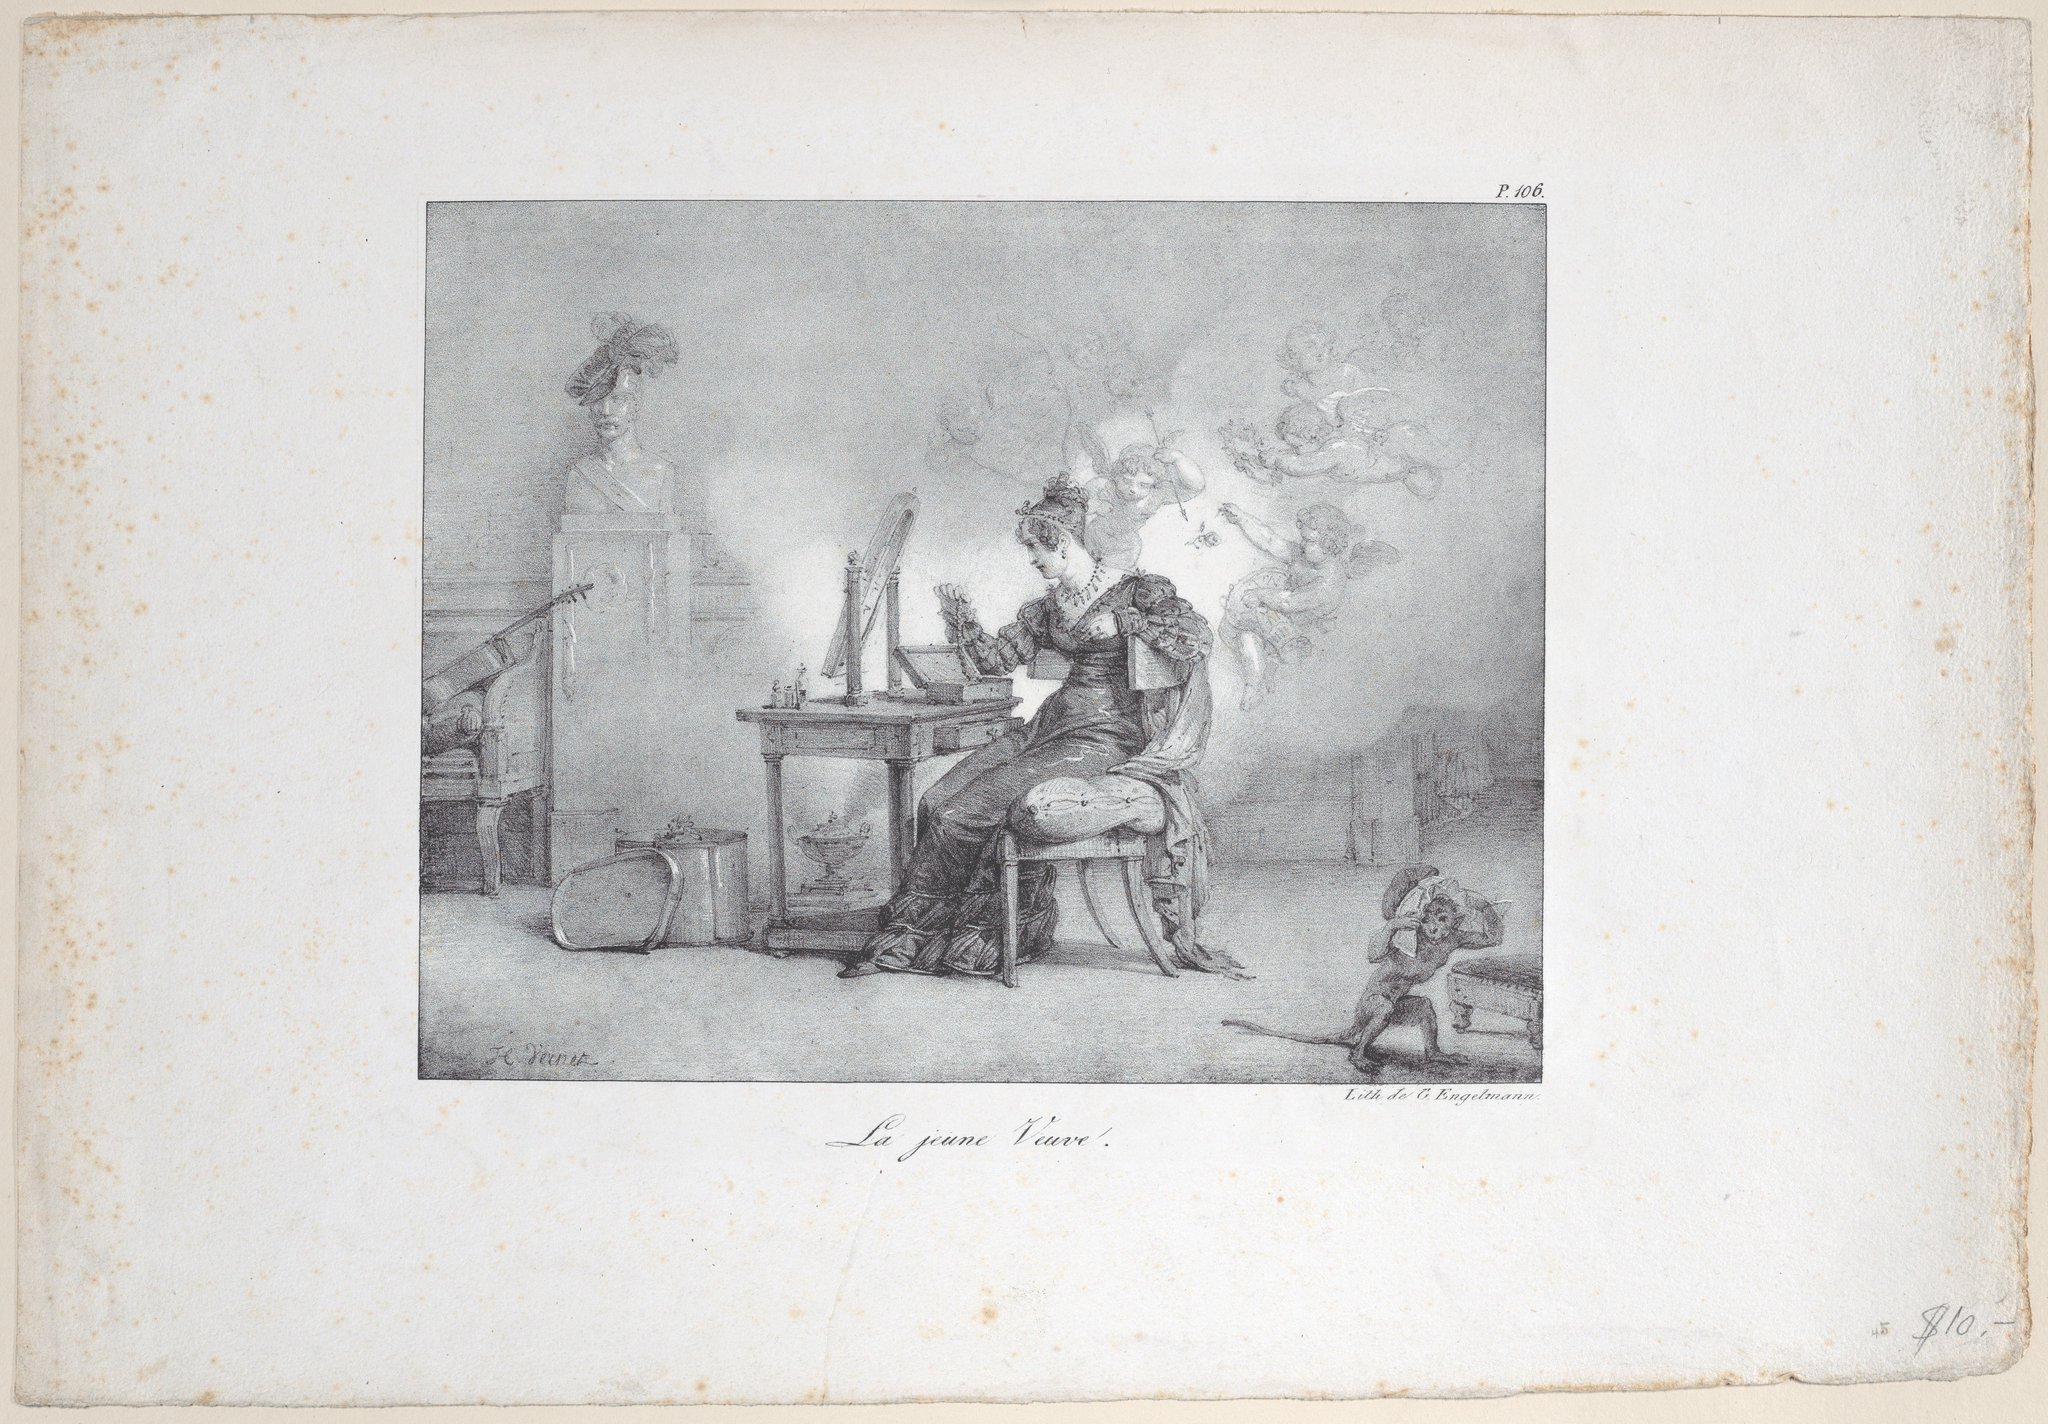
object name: print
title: The Young Widow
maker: horace vernet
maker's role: artist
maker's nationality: french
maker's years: 1789-1863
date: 1818-1821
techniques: lithograph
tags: women,cupid,monkeys,tables,mirrors